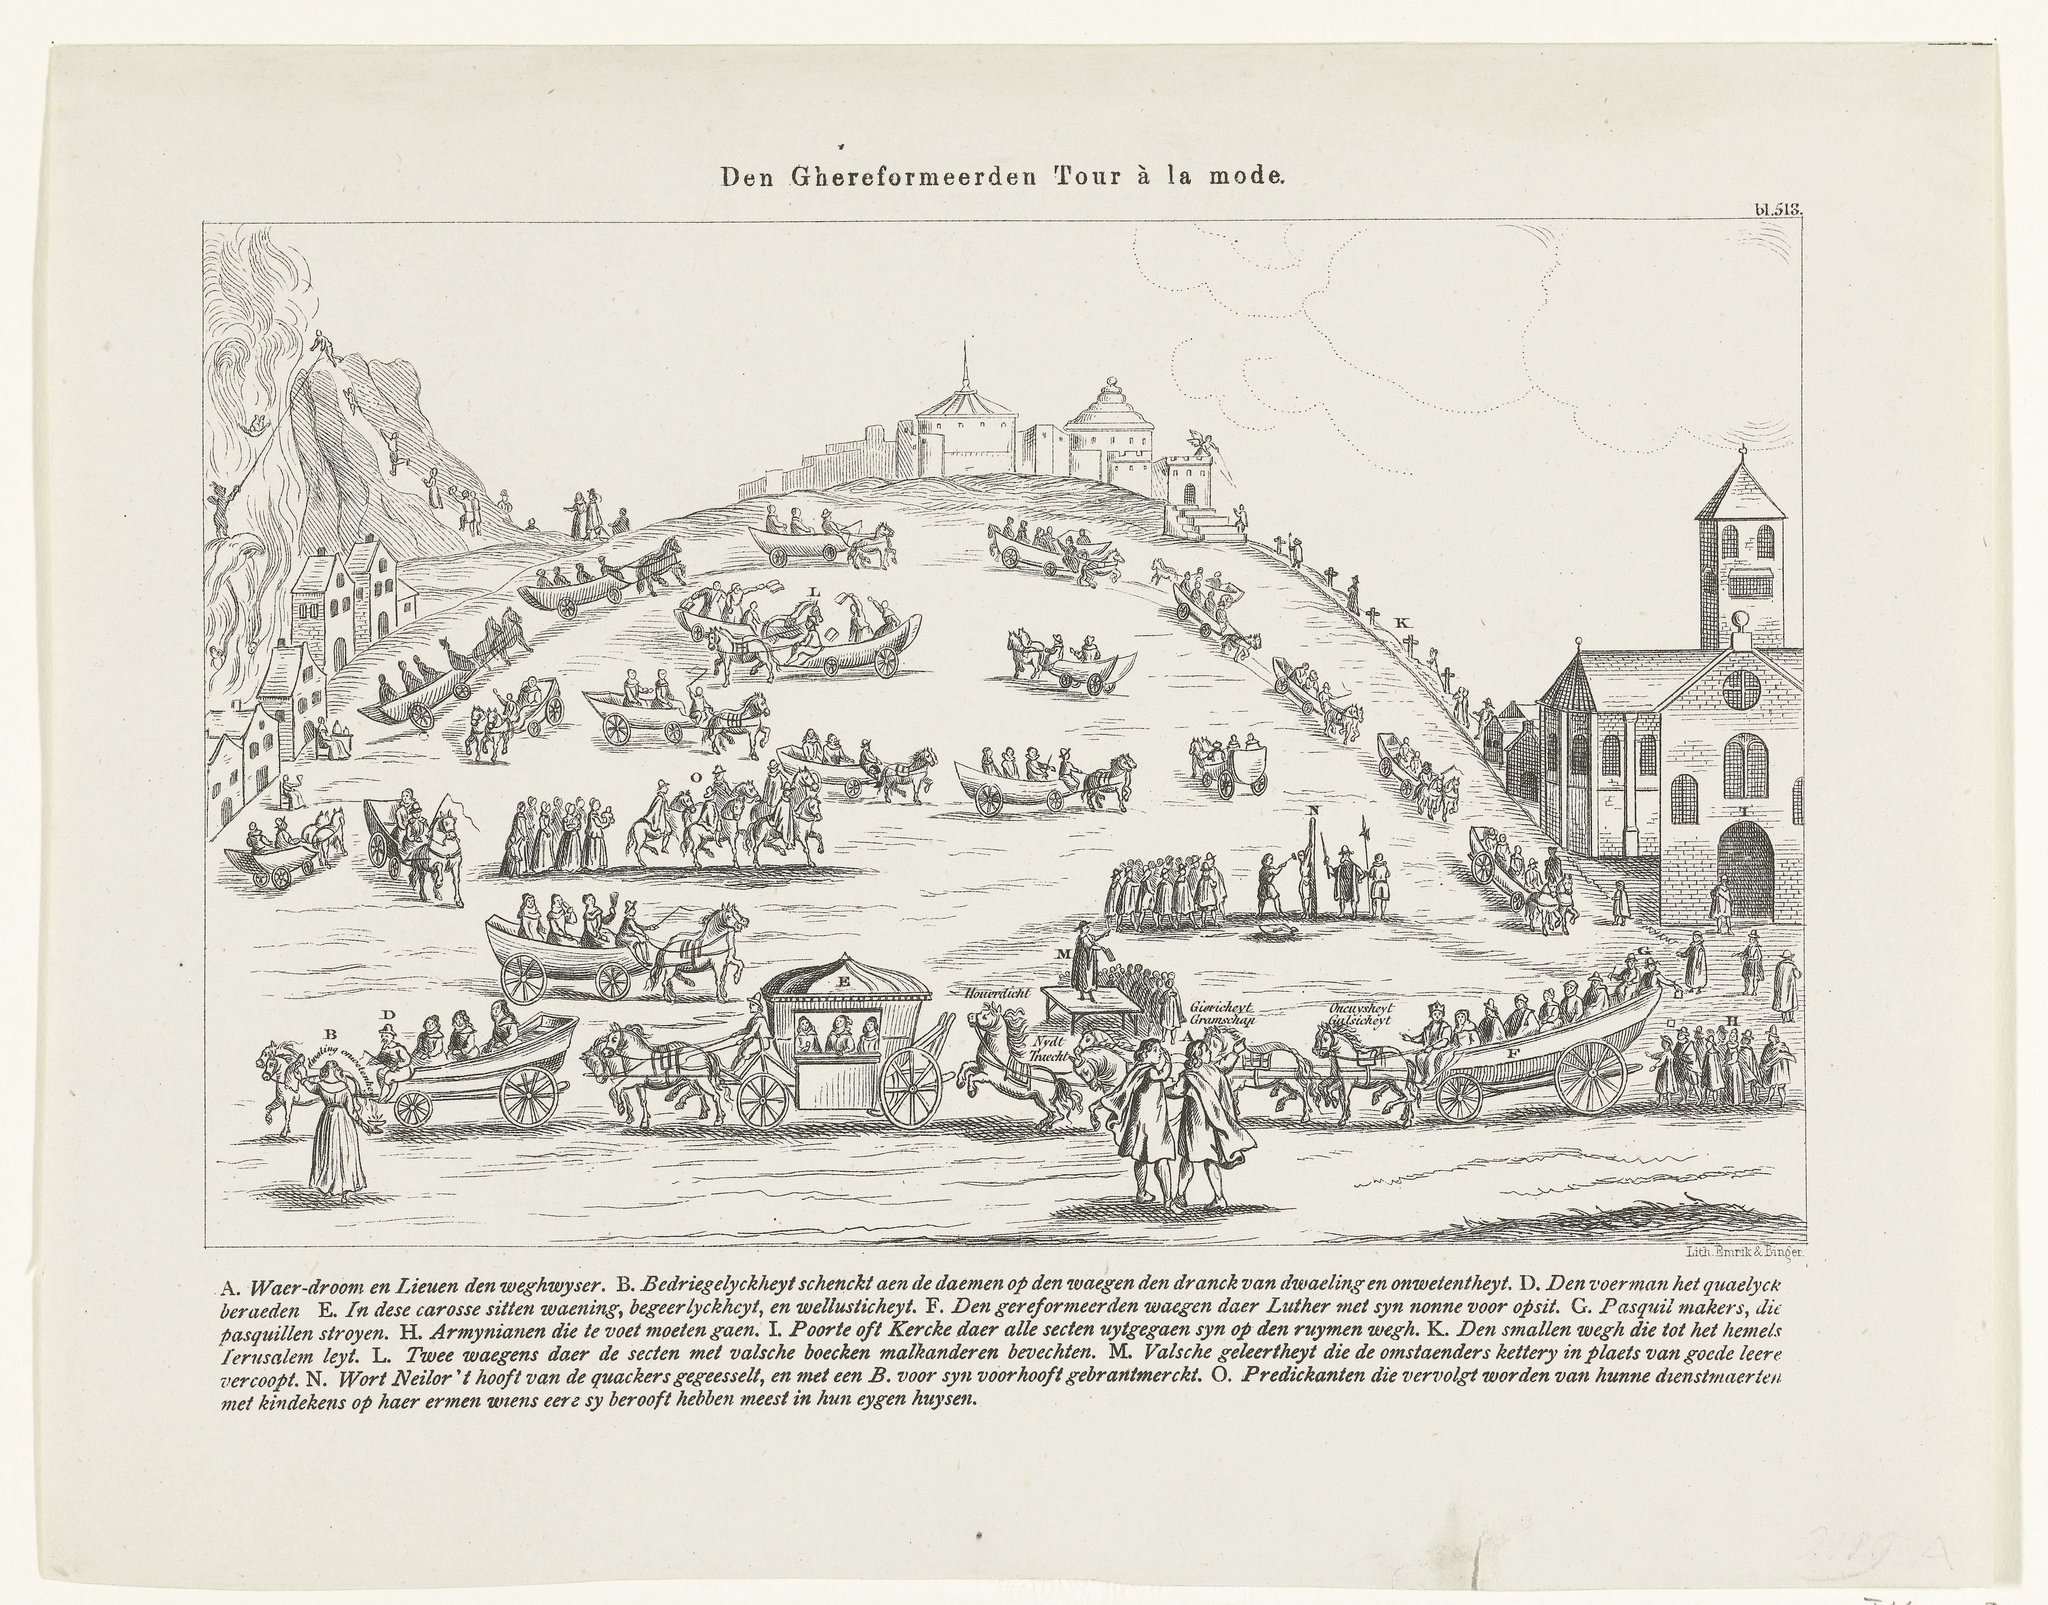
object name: print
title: Den ghereformeerden Tour à la mode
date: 1877-1879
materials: paper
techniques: lithograph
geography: netherlands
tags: the way to destruction is broad and the gate is wide; the way to life is narrow and the gate is straight ~ doctrine of christ on love, etc. (matthew 7:13-14; luke 13:24), political caricatures and satires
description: Reproductie van een spotprent op de protestanten, 1657. Veld met wagens van allerlei soorten protestanten en zondige begrippen die de kerk hebben verlaten en over de brede weg rijden naar de hel. Op de achtergrond de smalle weg naar het hemelse Jerusalem. In de voorstelling opschriften in het Nederlands en in het onderschrift de legenda A-O. Gemerkt rechtsboven: Bl. 513.